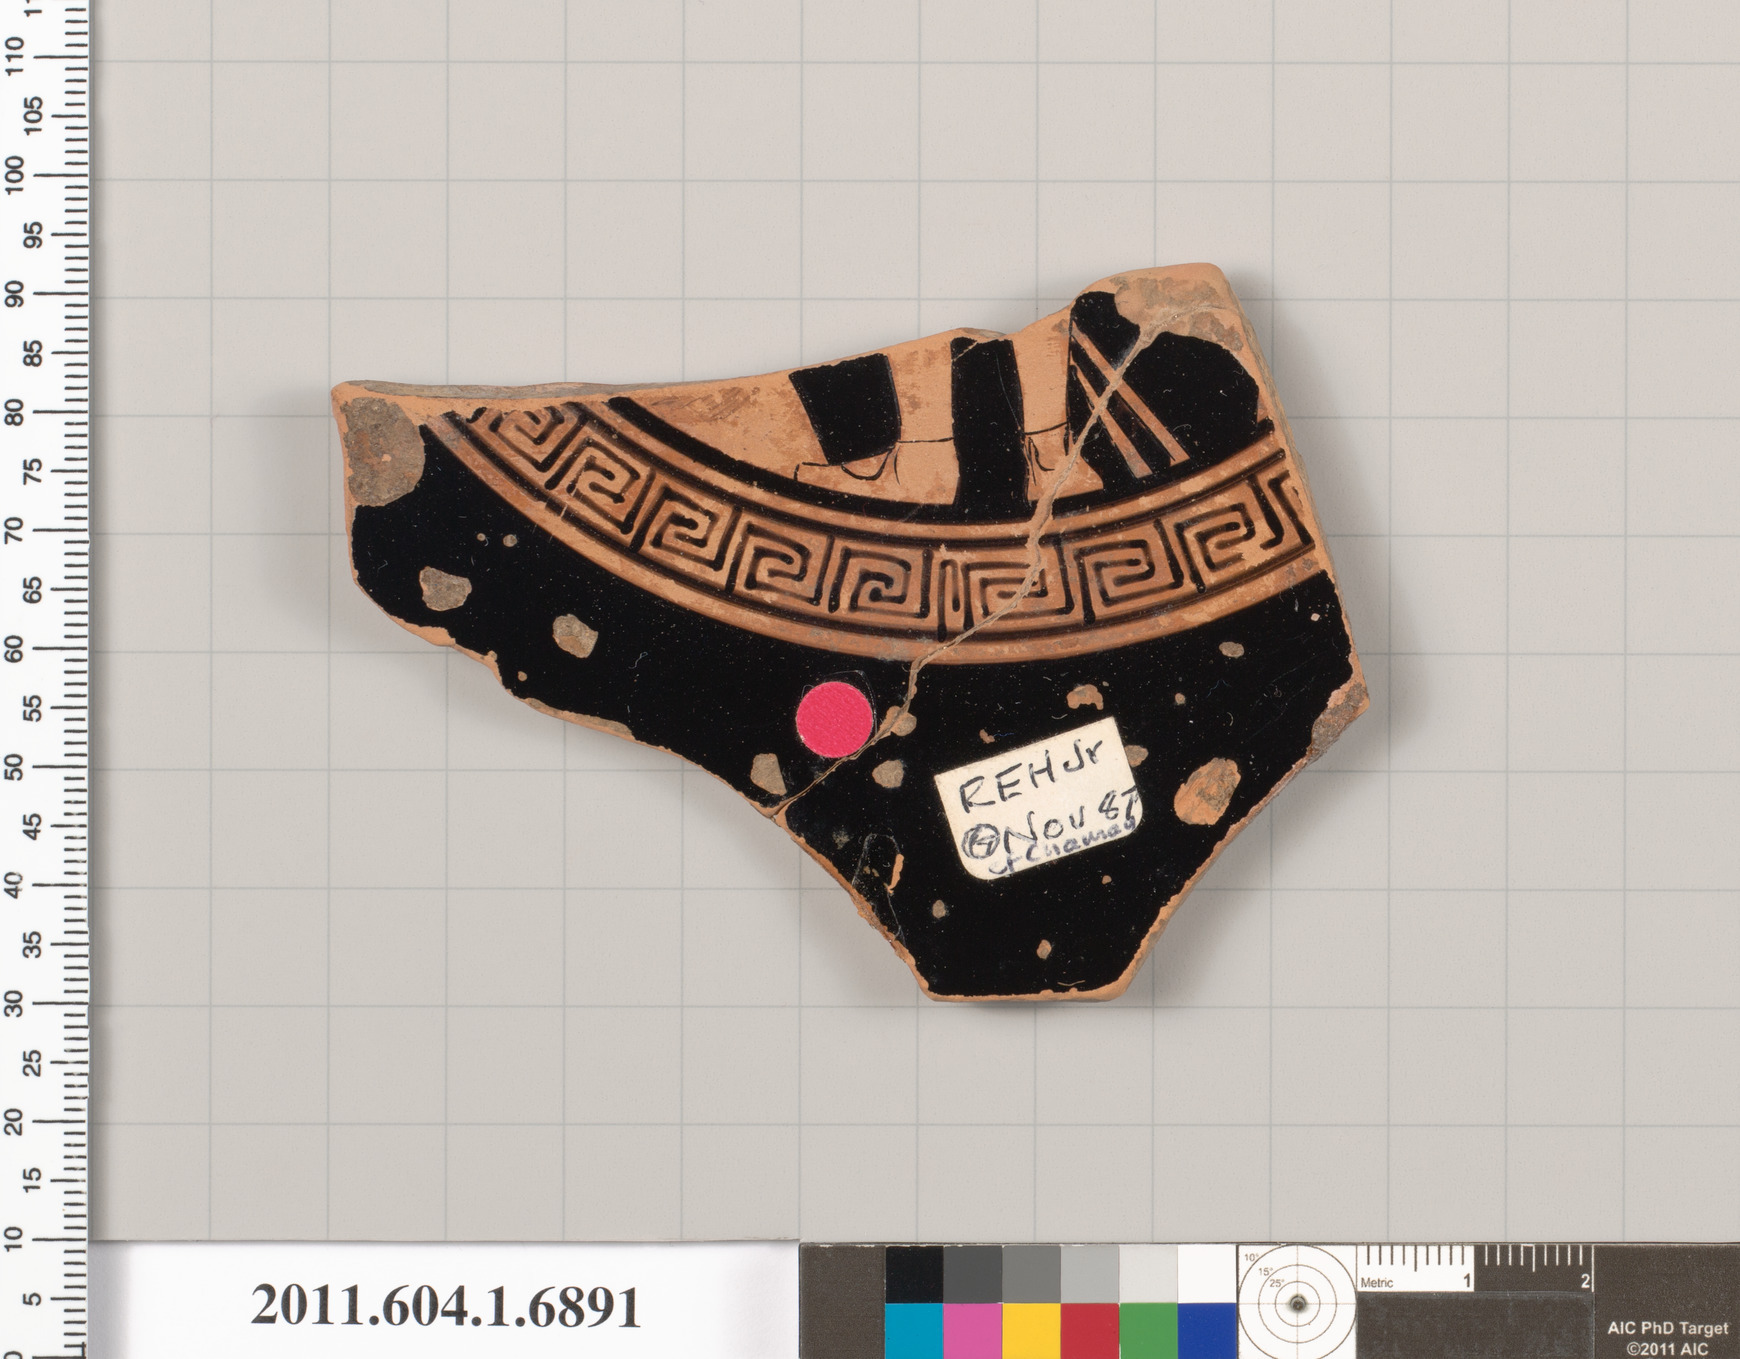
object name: kylix fragment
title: Terracotta fragment of a kylix (drinking cup)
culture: greek, attic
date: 490-470 BCE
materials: terracotta